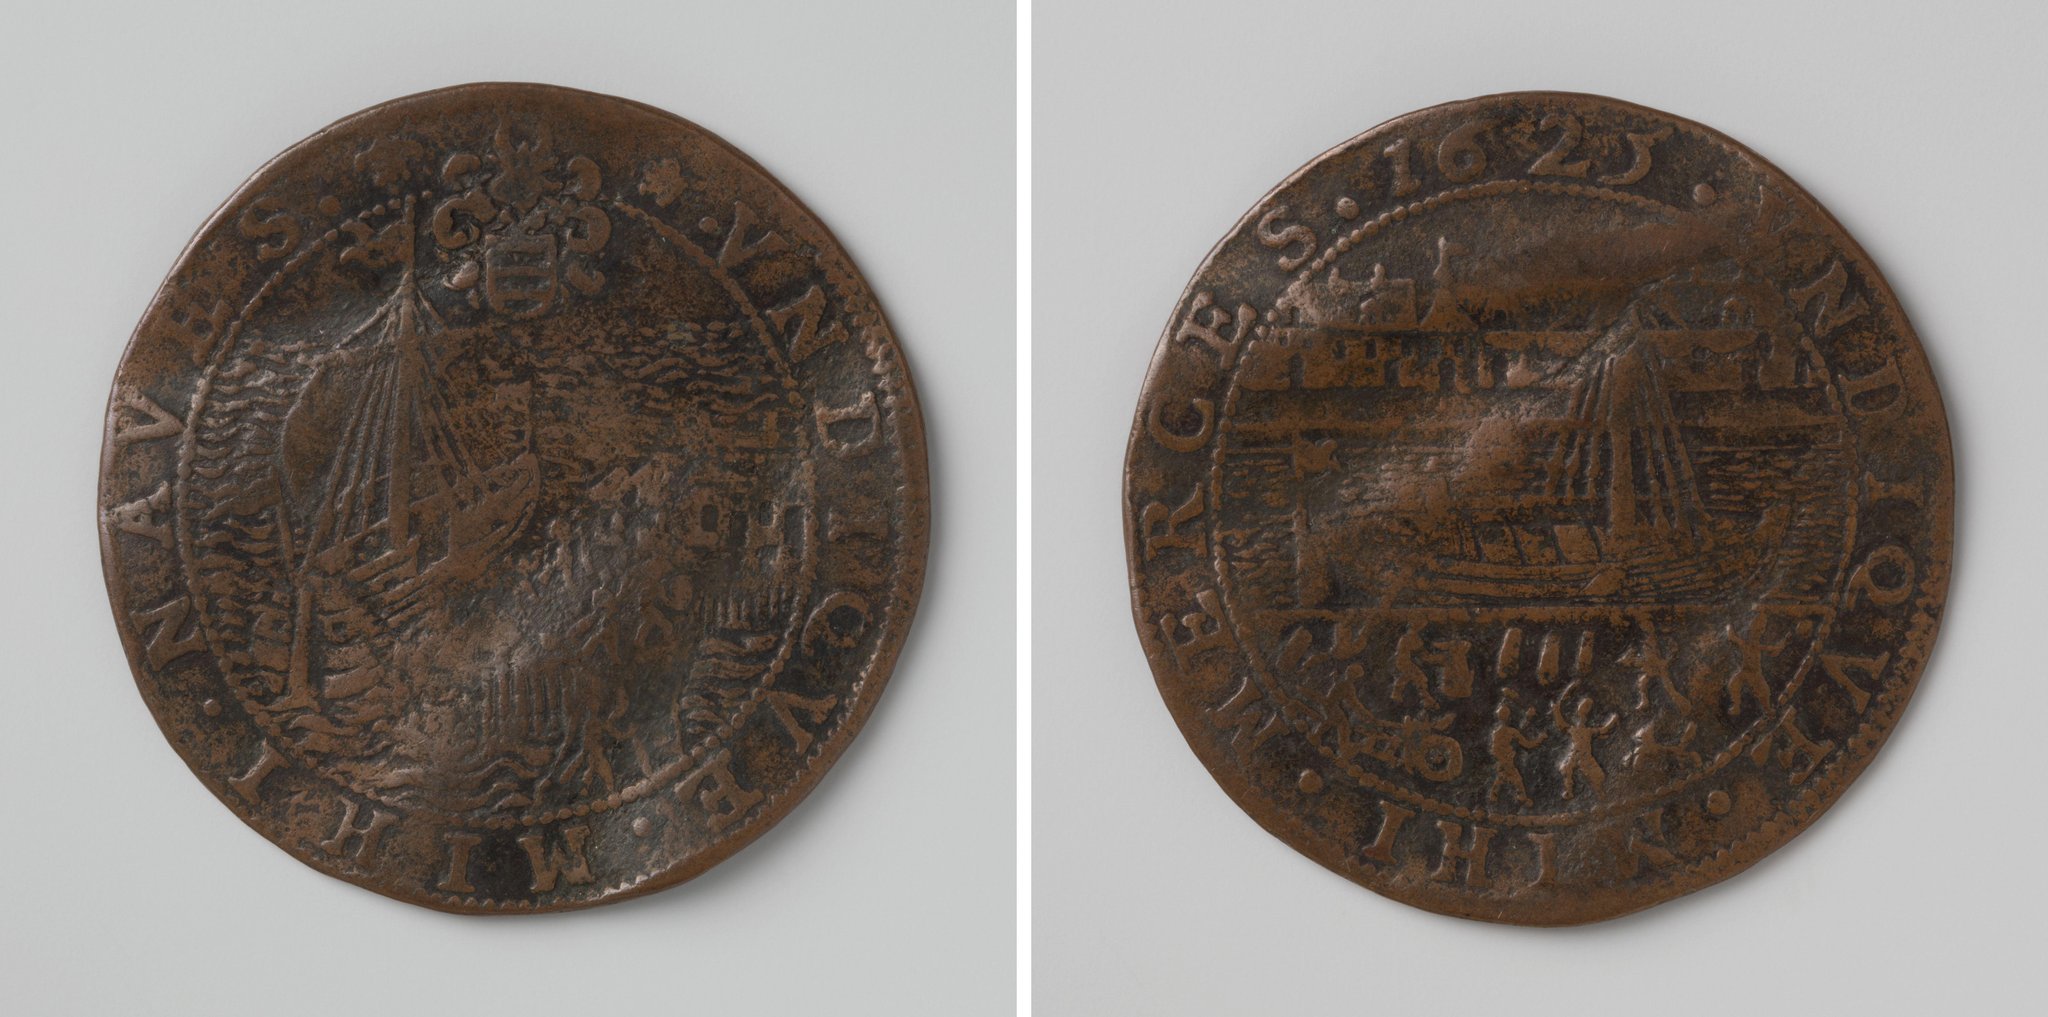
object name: jeton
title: Gerard d'Oyenbrugge, vijfentwintigste intendant van de vaart van Brussel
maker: balthasar laureys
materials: copper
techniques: striking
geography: brussels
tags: gerard d' oyenbrugge, willebroekse vaart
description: Koperen penning. Voorzijde: schip aan kade, waar reizigers uistappen onder gehelmd wapenschild binnen omschrift. Keerzijde: schip dat aan kade gelost wordt binnen omschrift